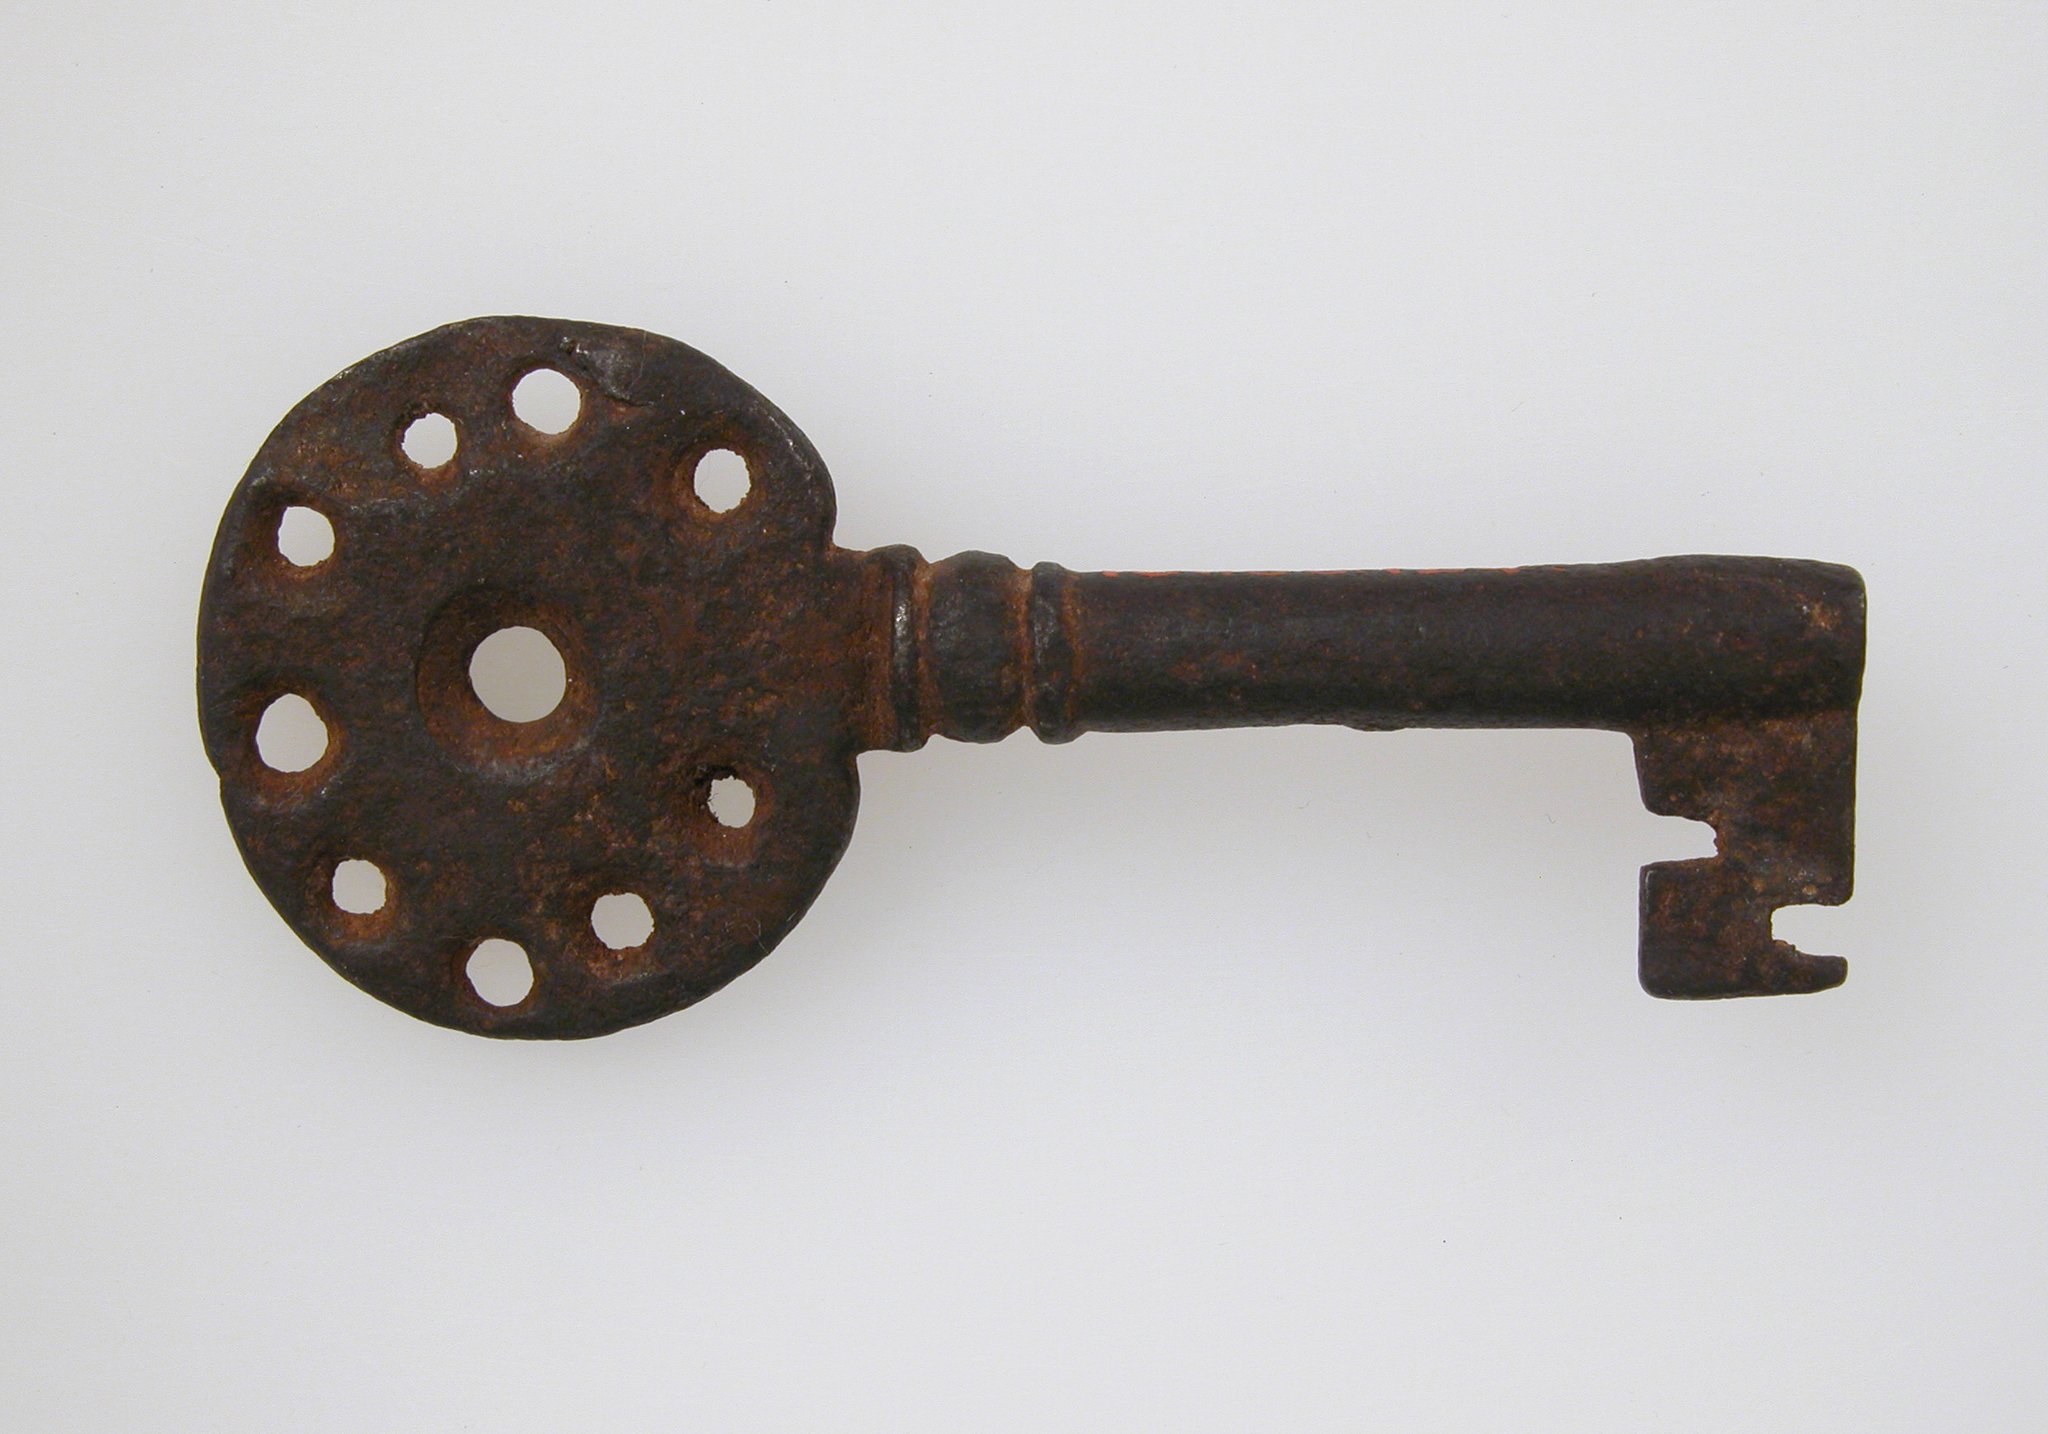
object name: key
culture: german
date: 1301-1500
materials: iron